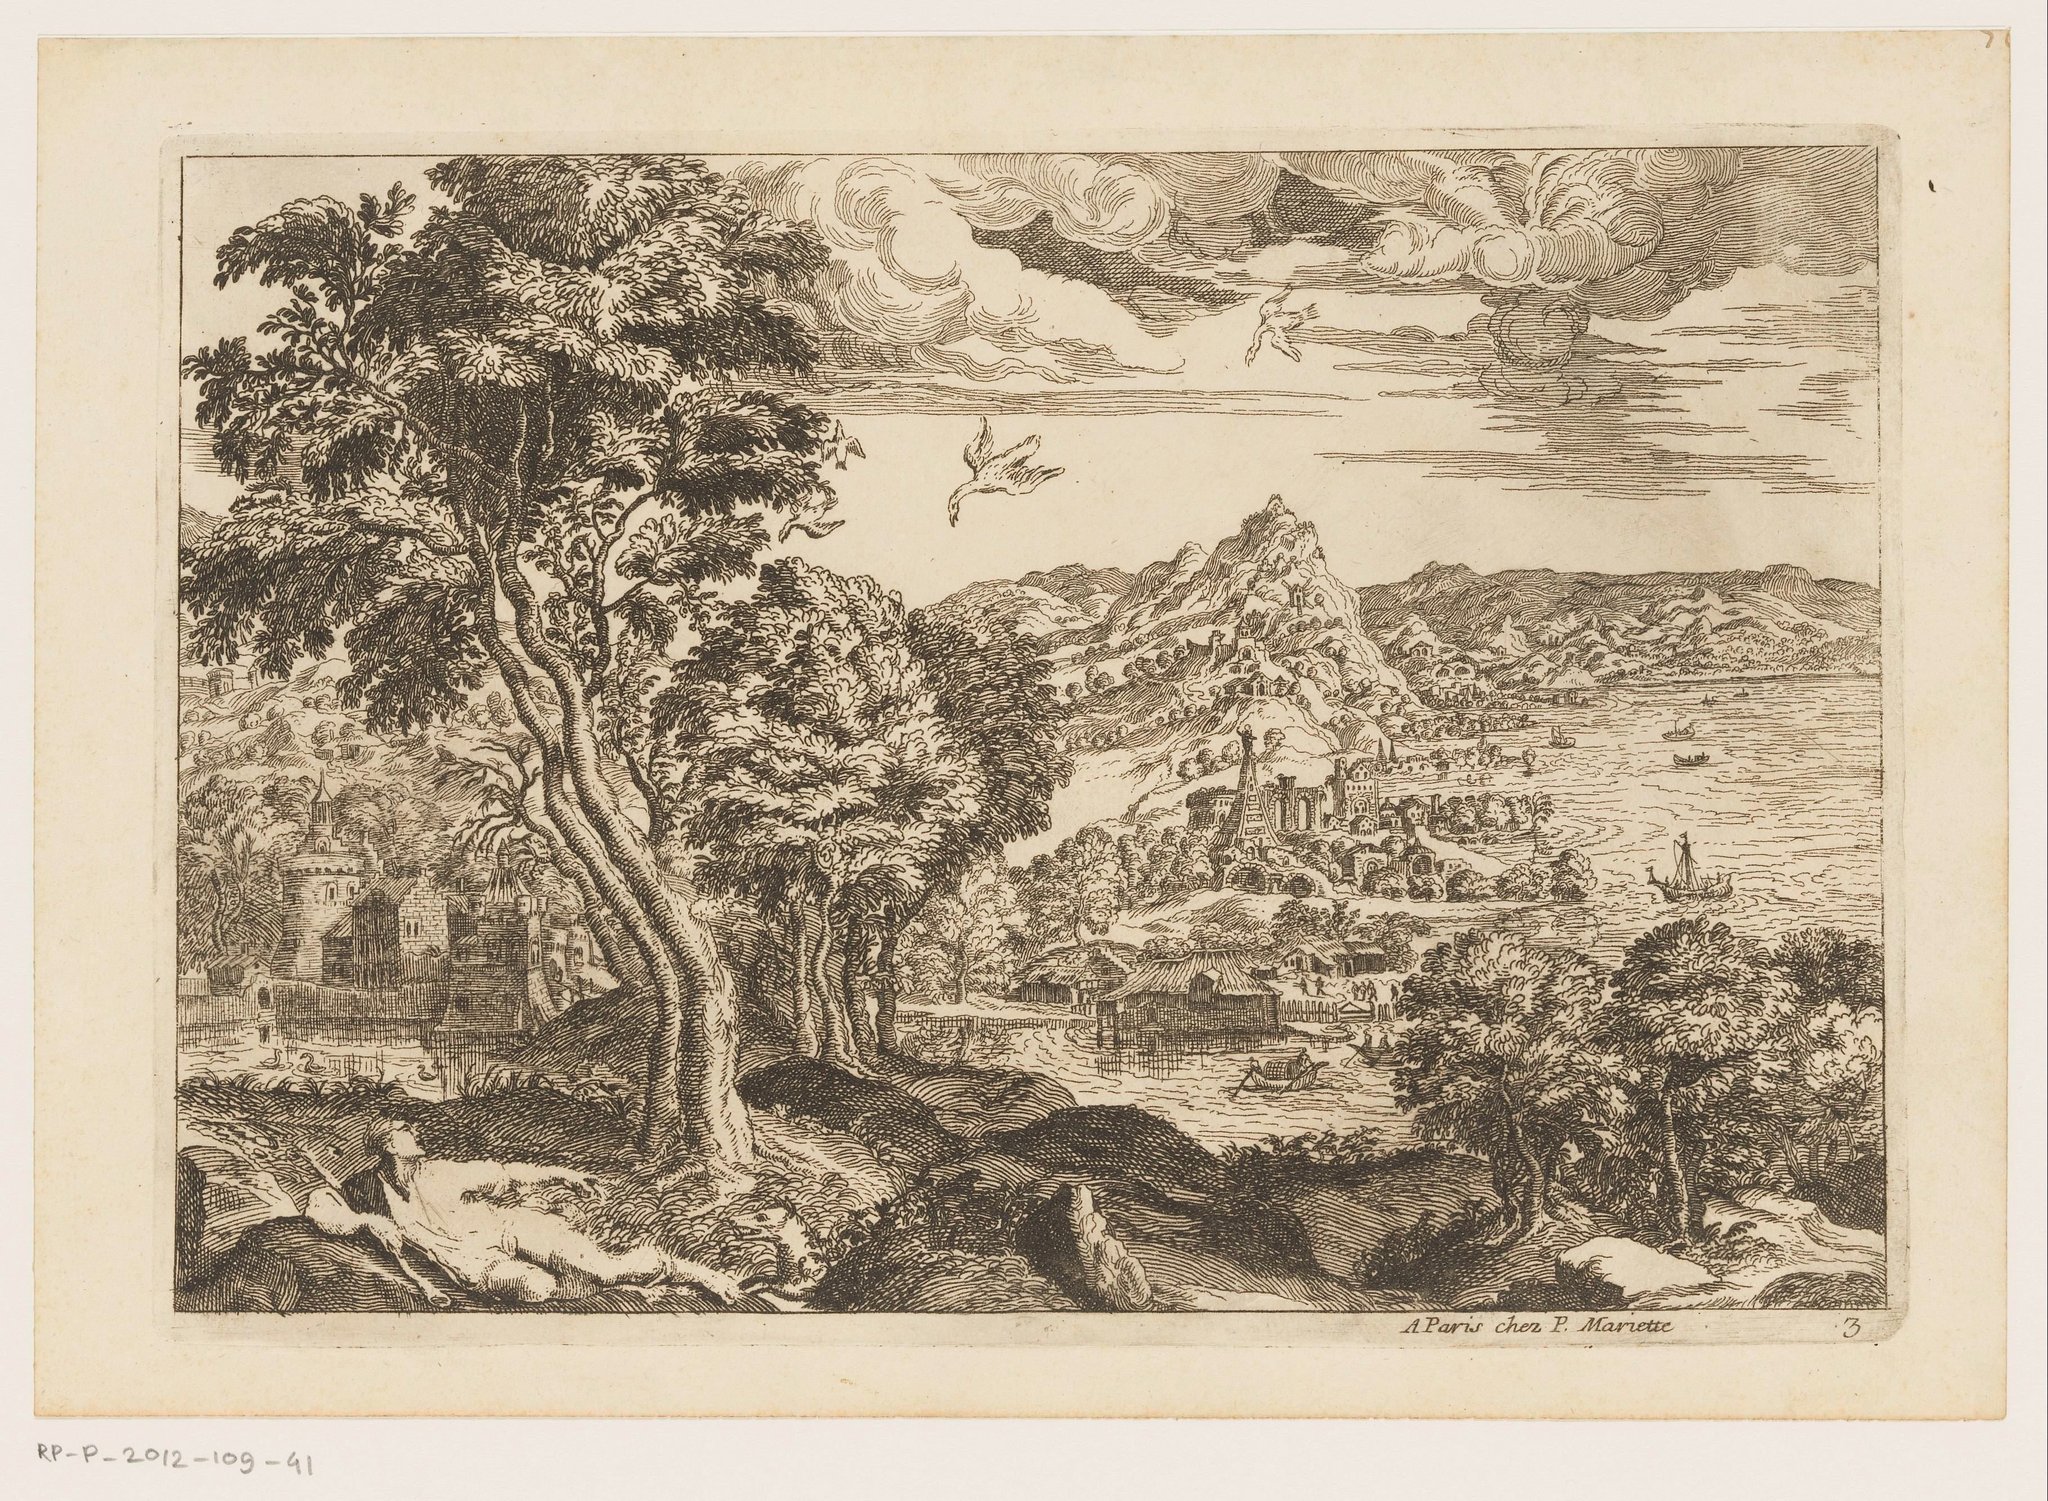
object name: print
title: Landschappen naar Titiaan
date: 1663-1726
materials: paper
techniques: etching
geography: paris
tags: birds, coast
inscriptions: collector's mark: Lugt 3473, collector's mark: Lugt 2228, collector's mark: Lugt 3474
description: Maakt deel uit van vierentwintigdelige serie met landschappen naar Titiaan en Campagnola.